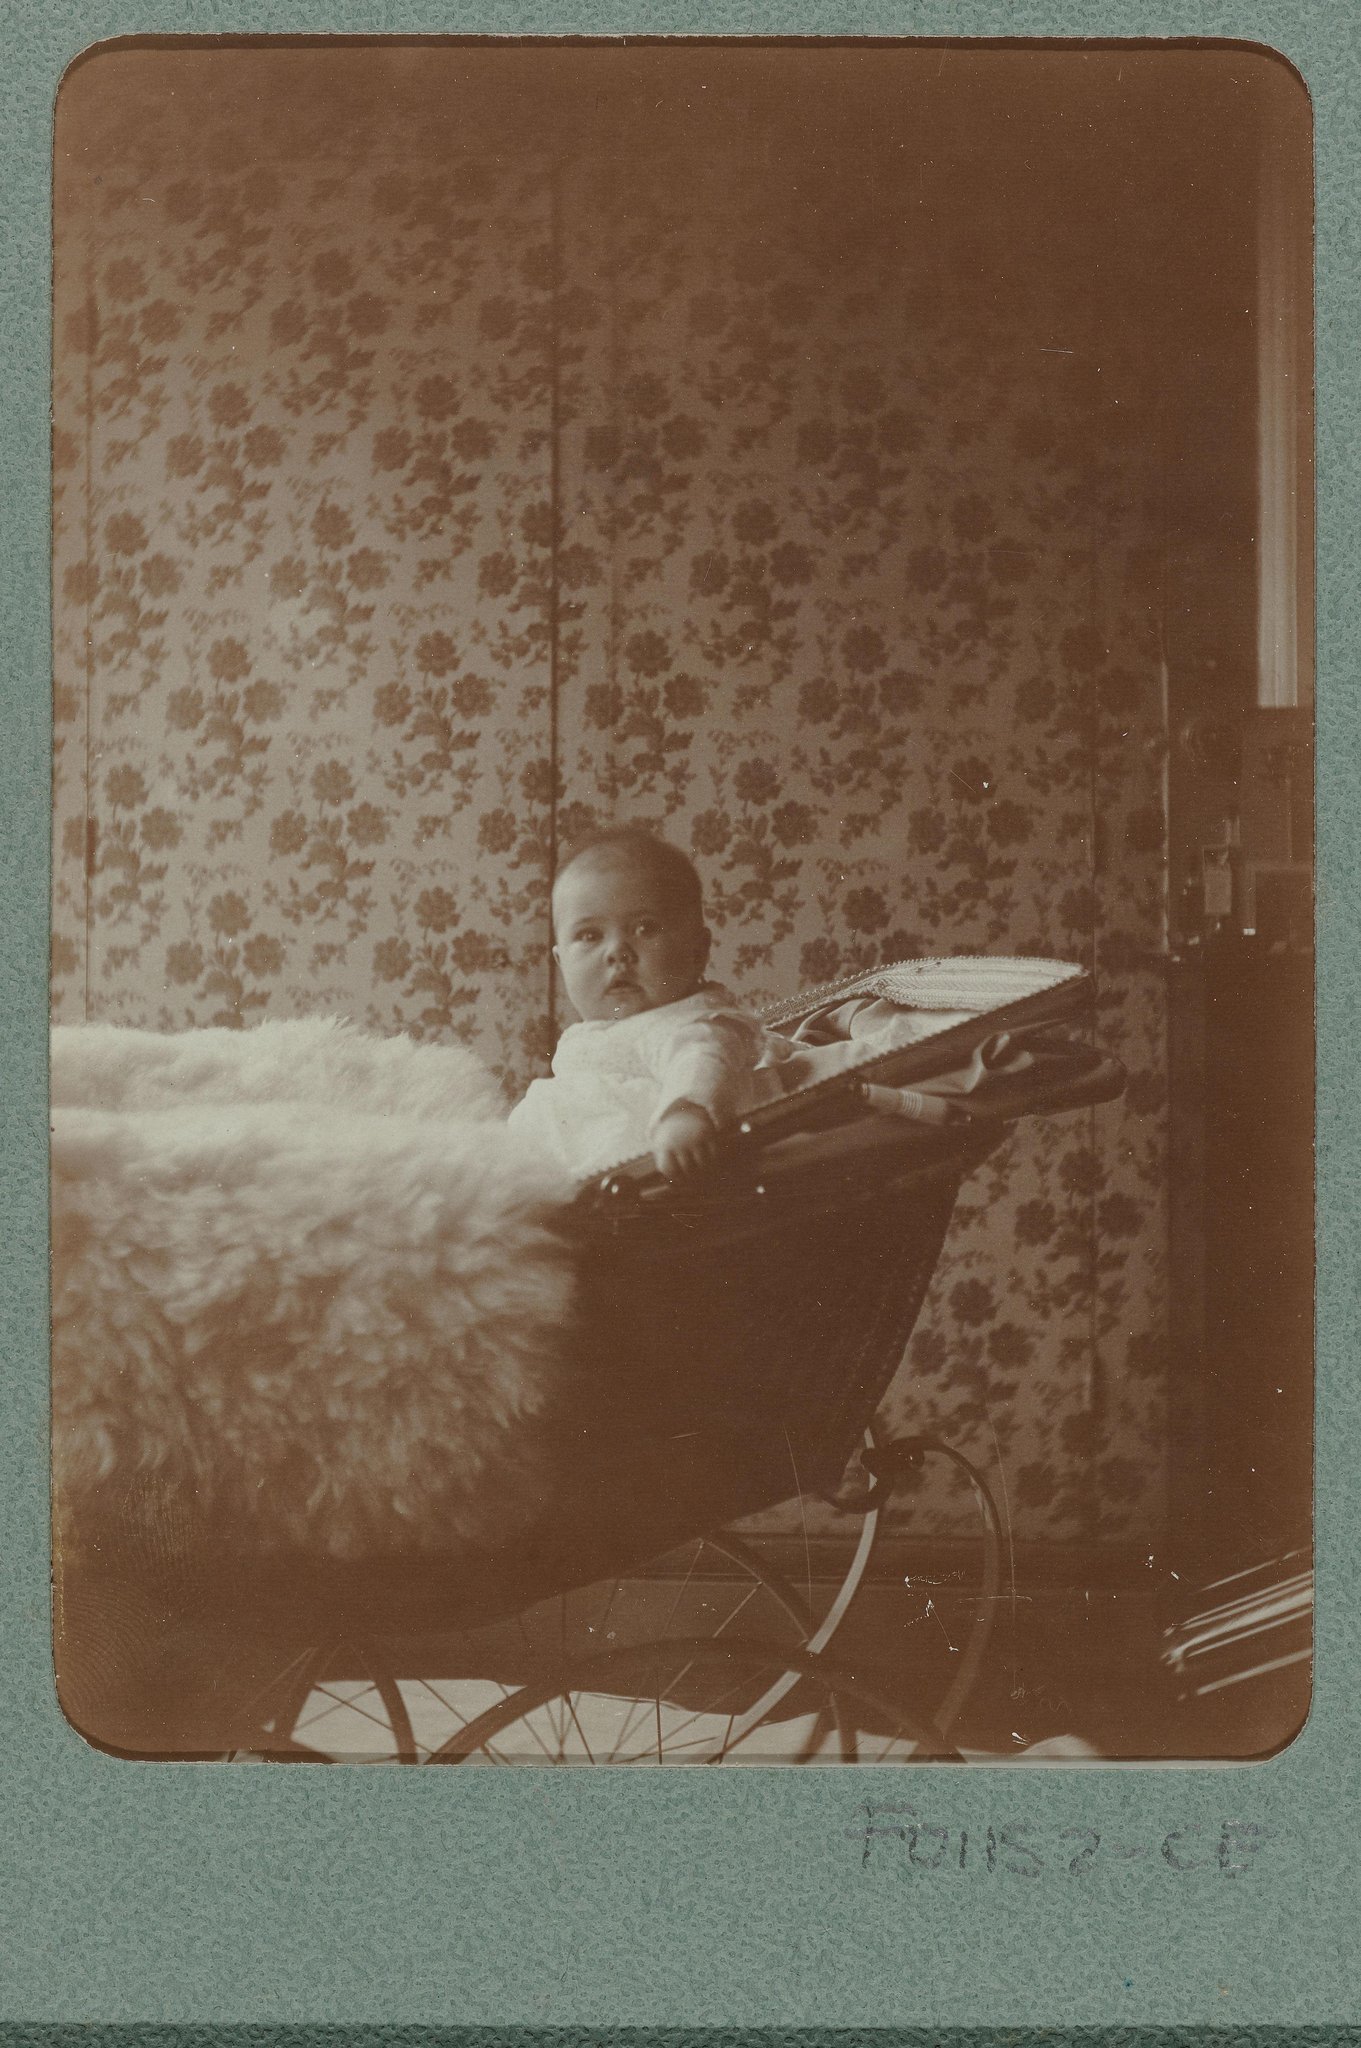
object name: album leaf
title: Baby zittend in een kinderwagen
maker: christiaan otto roelofs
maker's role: fotograaf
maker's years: 1882-1970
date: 1900-1915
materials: photographic support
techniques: gelatin silver print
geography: netherlands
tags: baby-carriage, pram, perambulator, historical persons, infant, baby